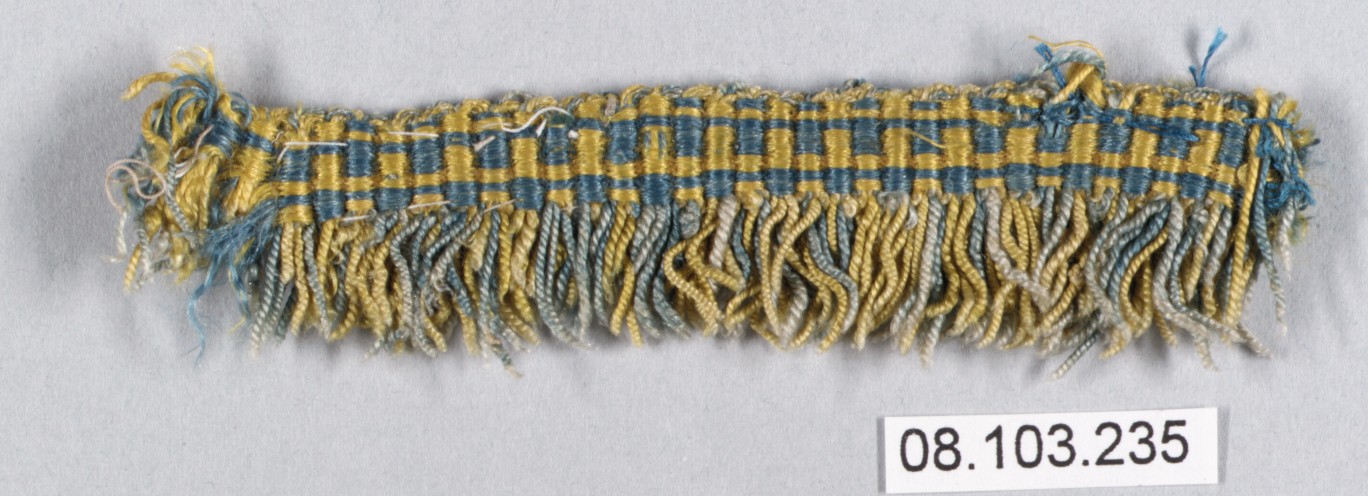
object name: gimp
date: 1701-1800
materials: silk